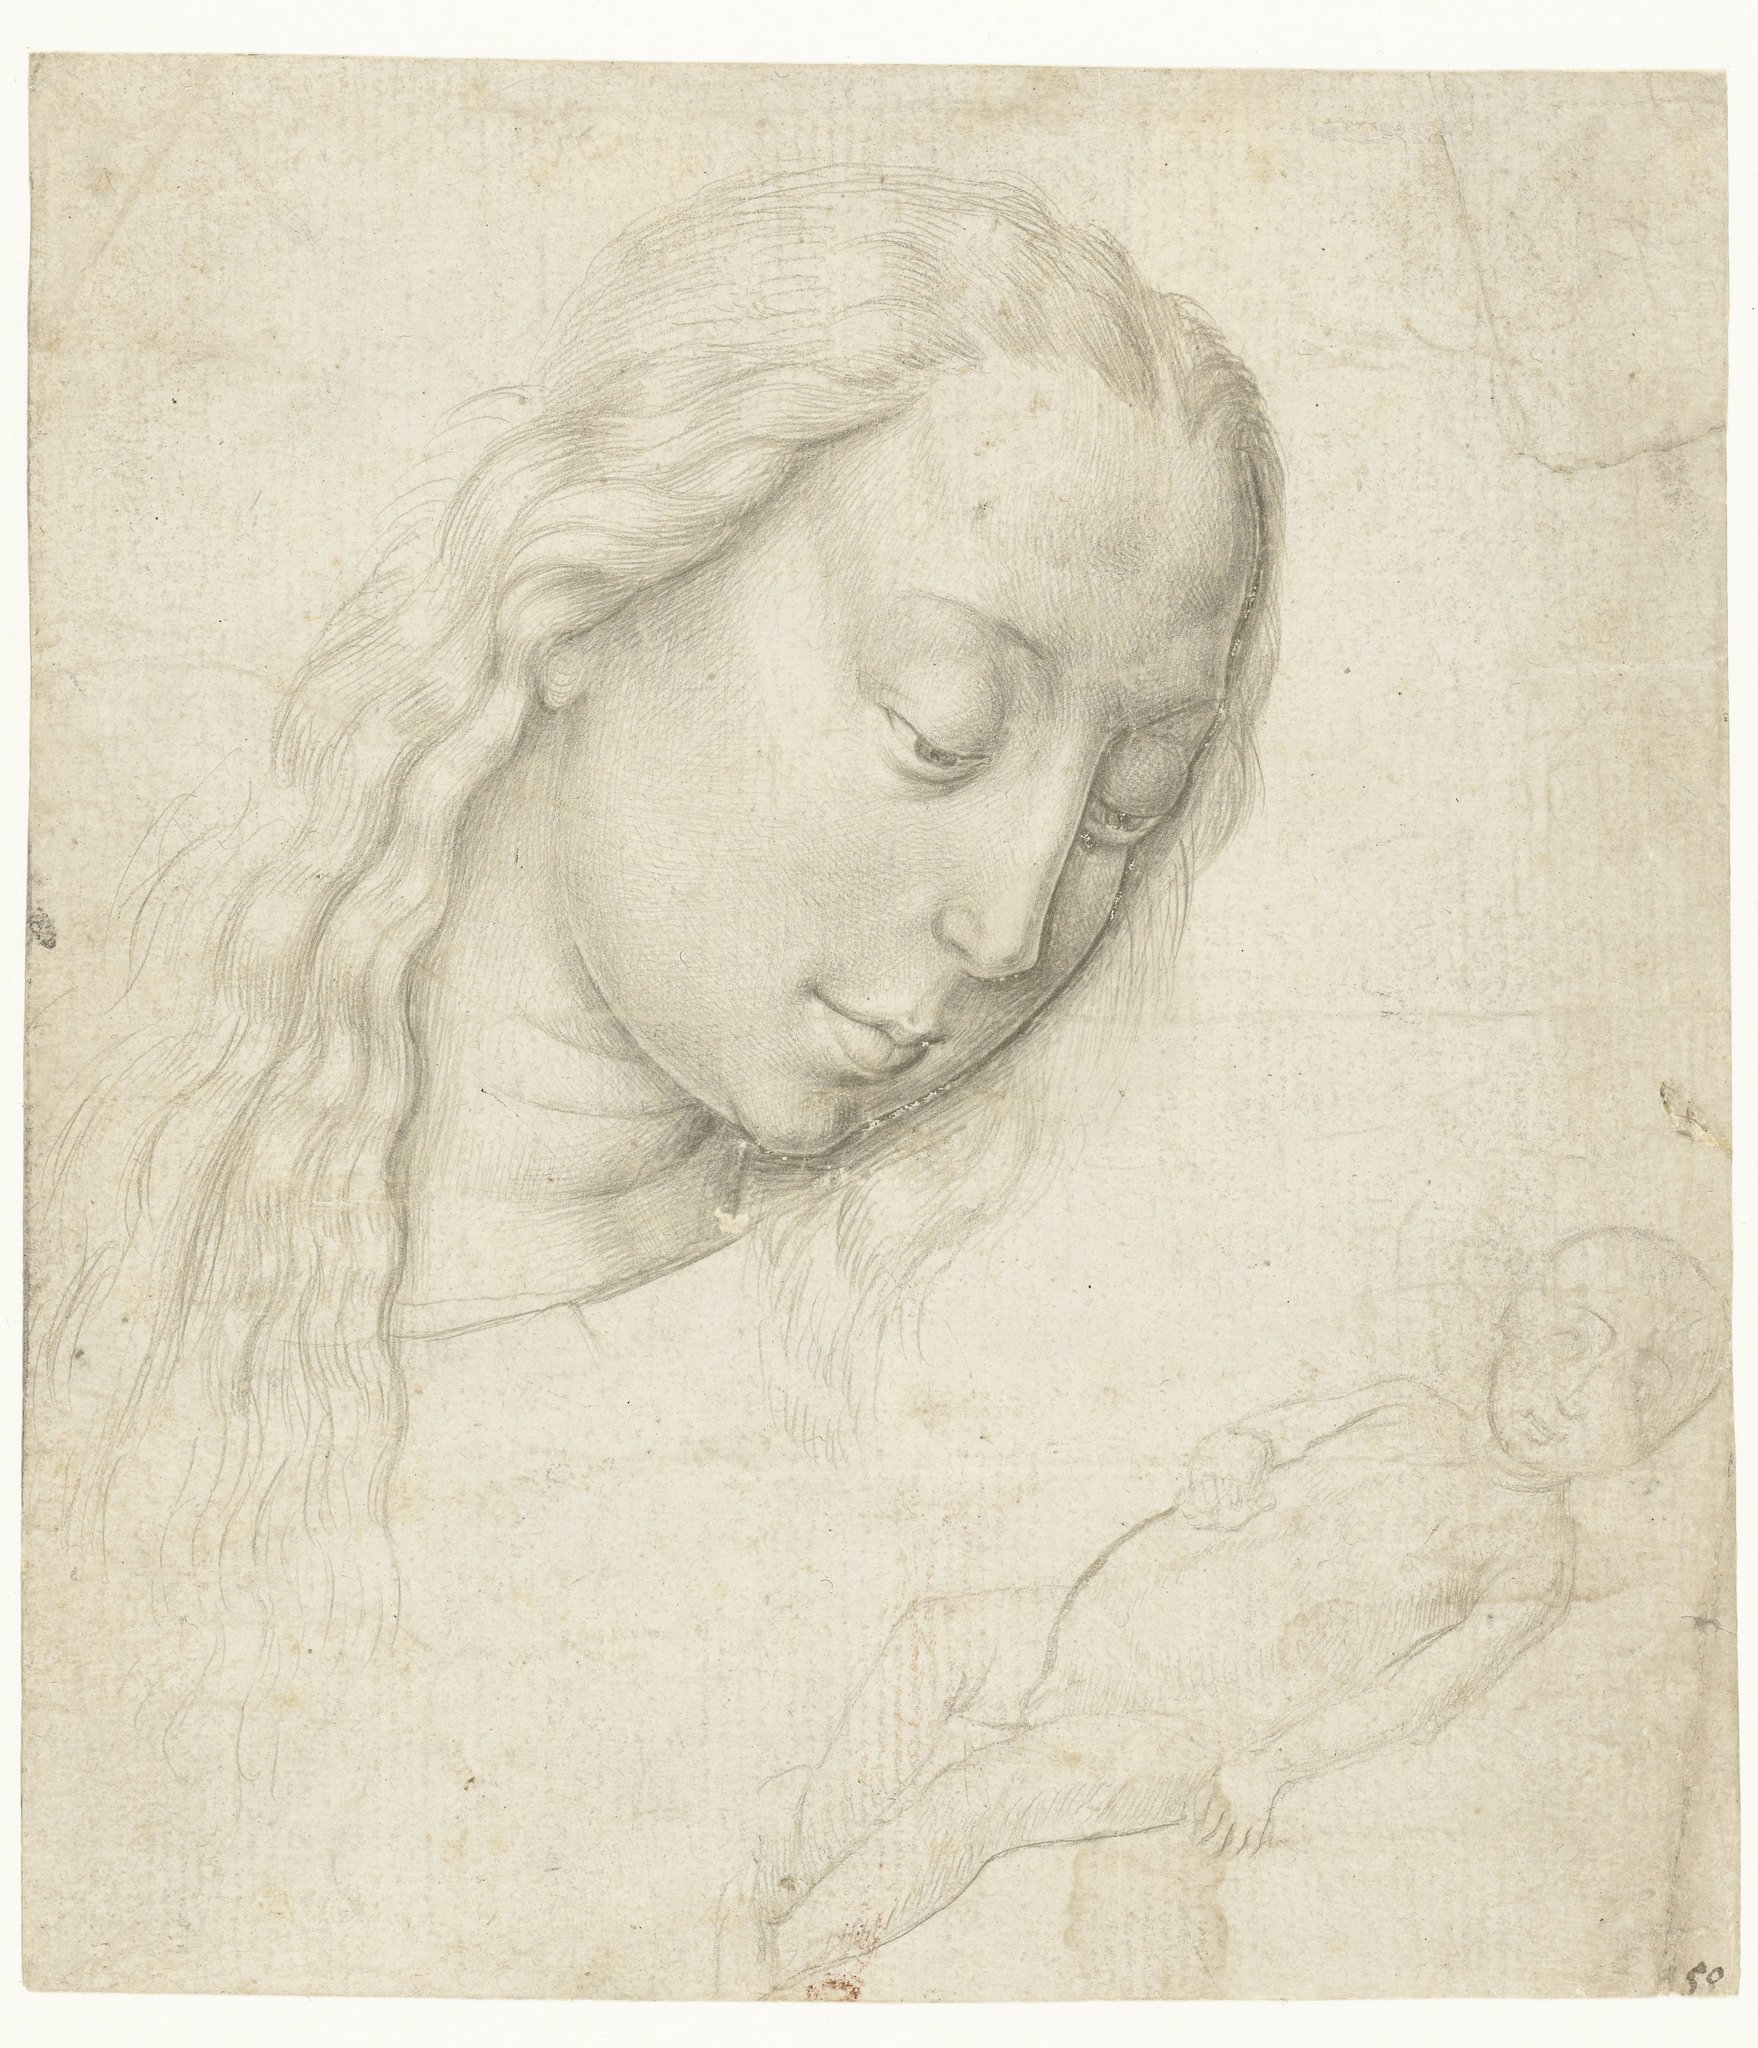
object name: drawing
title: Hoofd van Maria met het Christuskind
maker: meester van de legende van de heilige lucia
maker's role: painter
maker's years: 1430-1509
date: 1470-1480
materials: paper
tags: madonna: i.e. mary with the christ-child